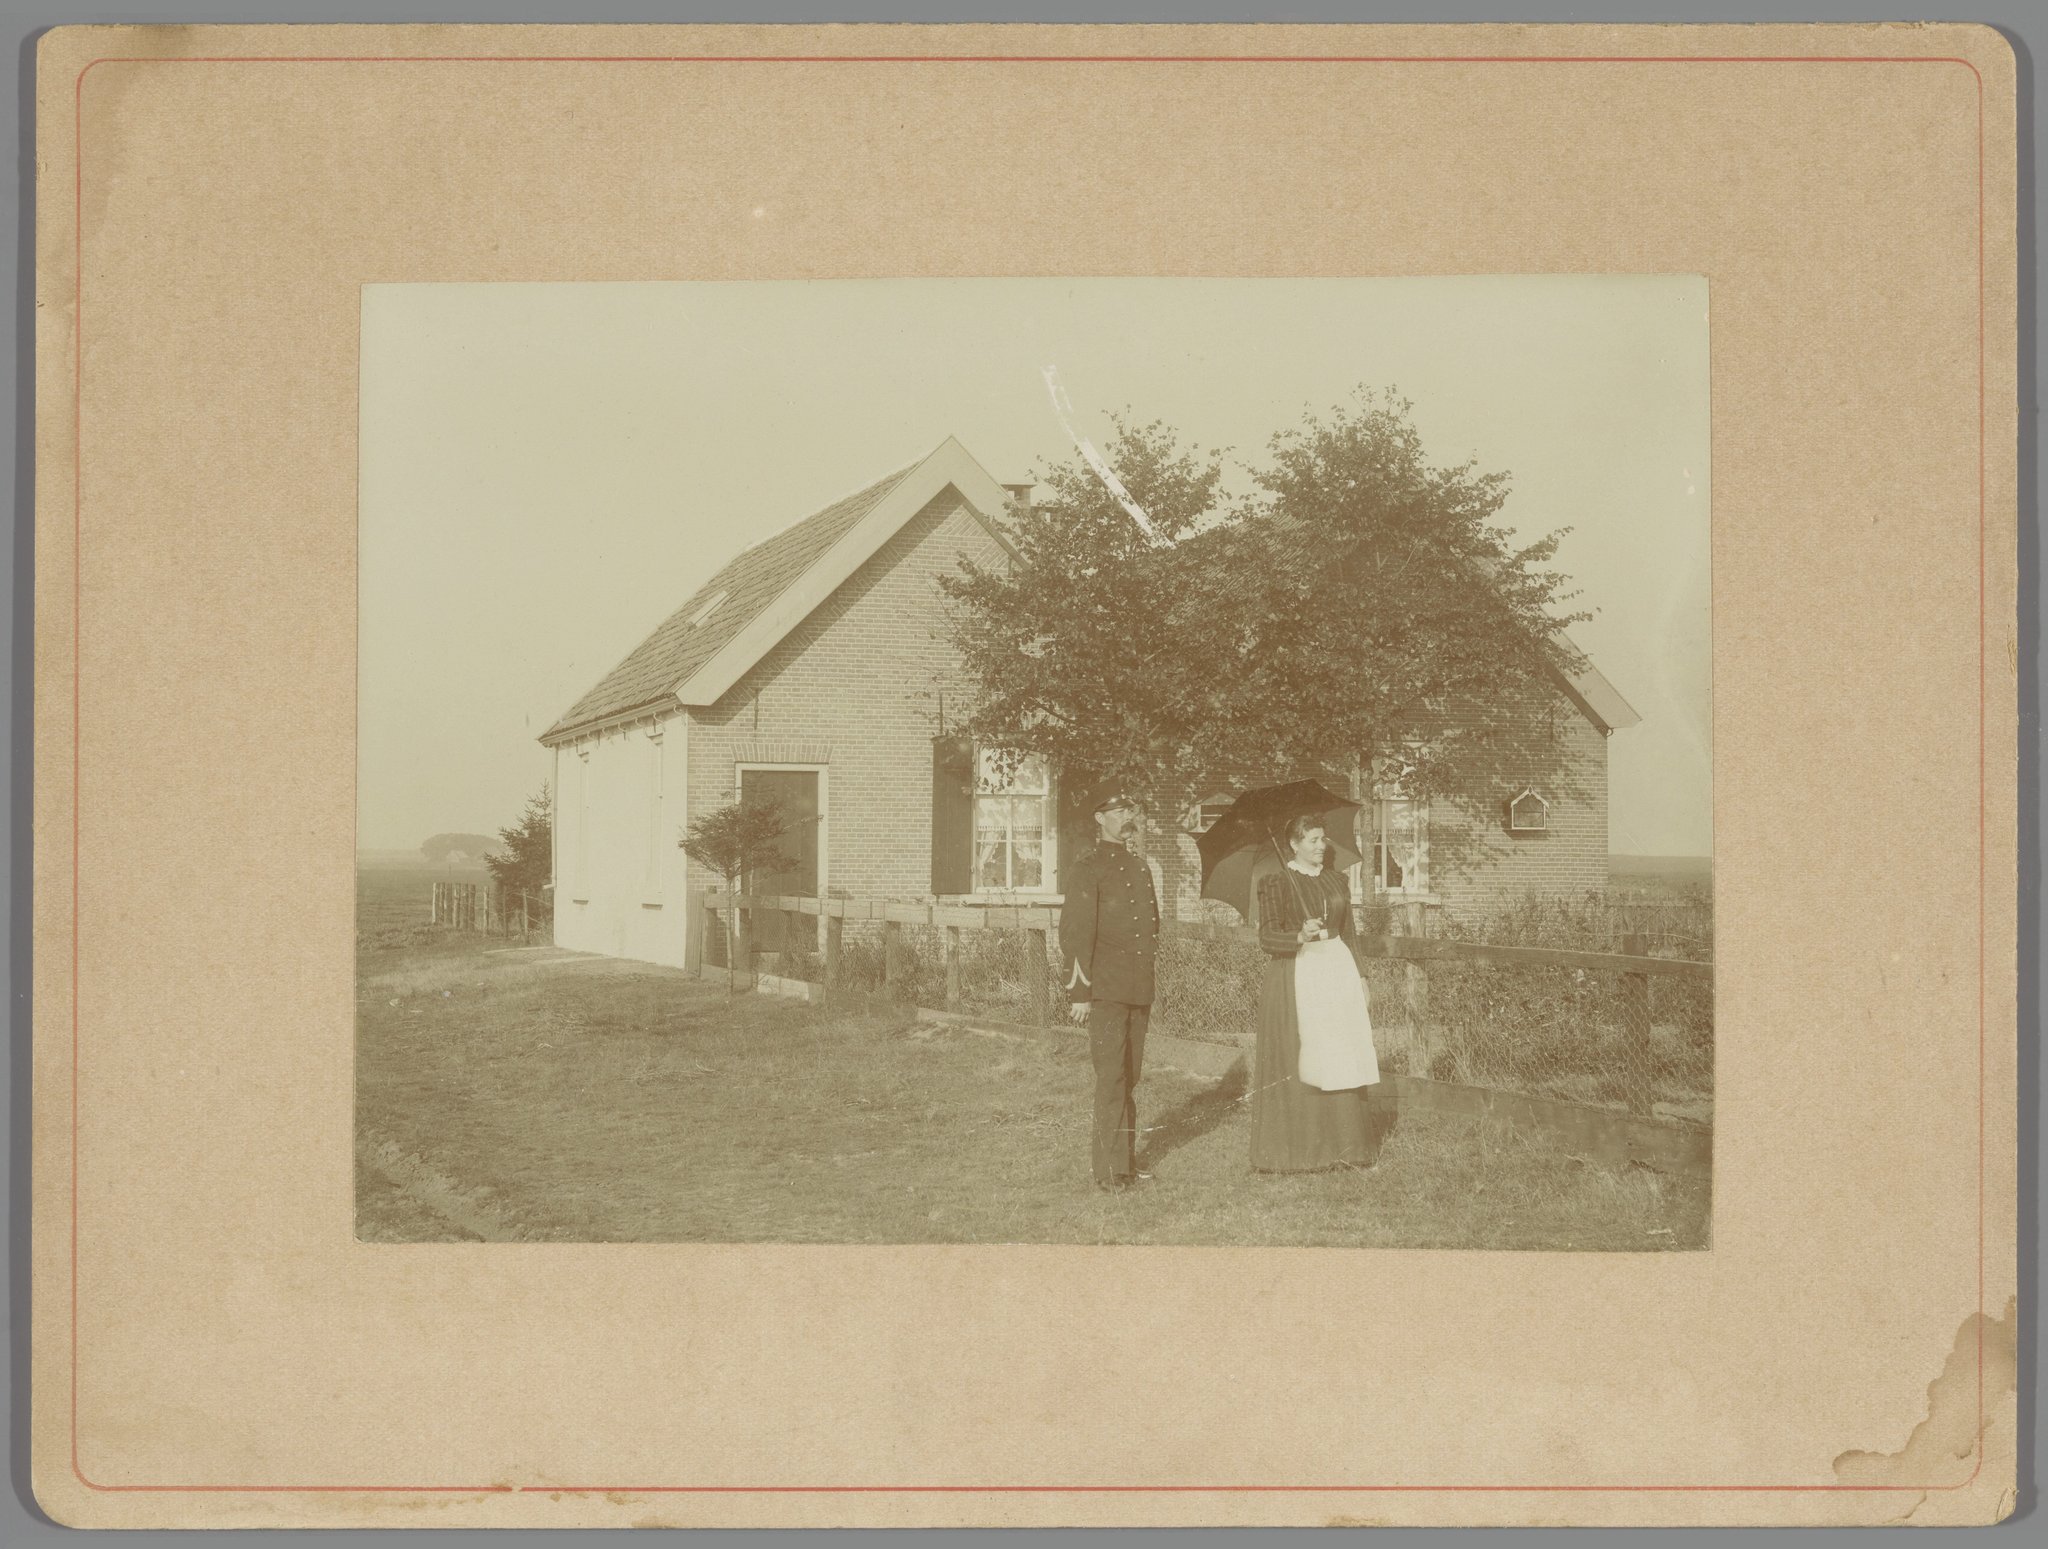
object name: photograph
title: Veldwachter en een vrouw met paraplu voor een woonhuis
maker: Anonymous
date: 1890-1910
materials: paper, cardboard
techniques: collodion silver print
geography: netherlands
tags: policeman, constable, country-house